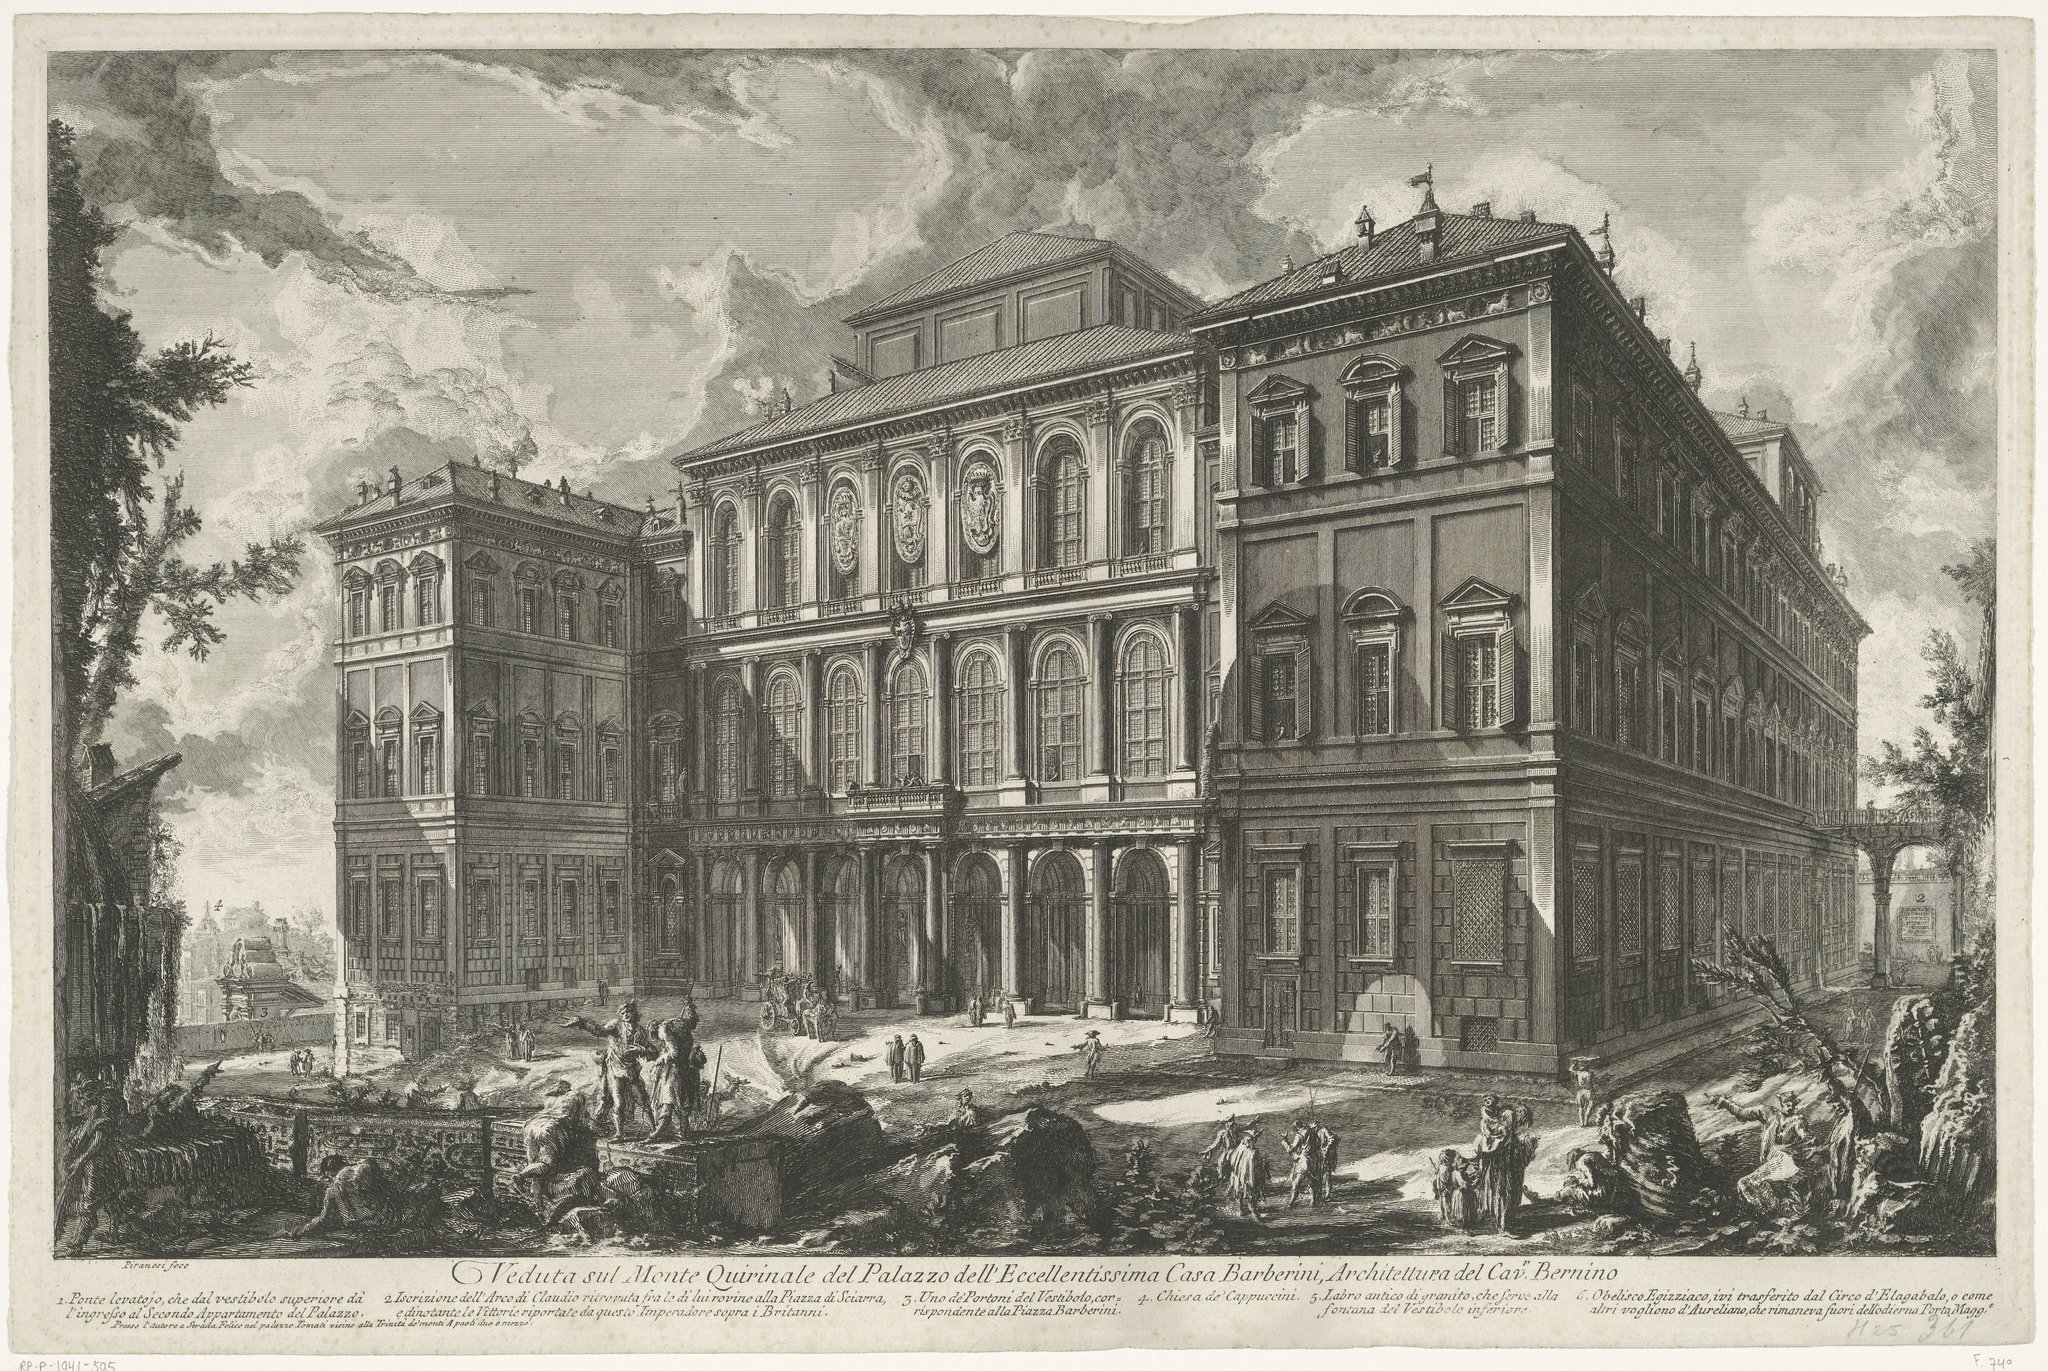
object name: print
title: Vedute di Roma disegnate ed incise da Giambattista Piranesi architetto Ve(nez)iano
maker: giovanni battista piranesi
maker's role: designer, draughtsman, print maker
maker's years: 1720-1778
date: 1748-1778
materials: paper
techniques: etching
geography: rome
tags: hôtel, i.e. small palace in city, rome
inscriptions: collector's mark: Lugt 2228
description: Deze prent maakt deel uit van de serie 'Vedute di Roma'. Piranesi werkte aan deze 135 platen tellende serie tussen 1748 en zijn dood in 1778. Francesco Piranesi voegde later nog twee prenten toe aan de reeks van zijn vader.